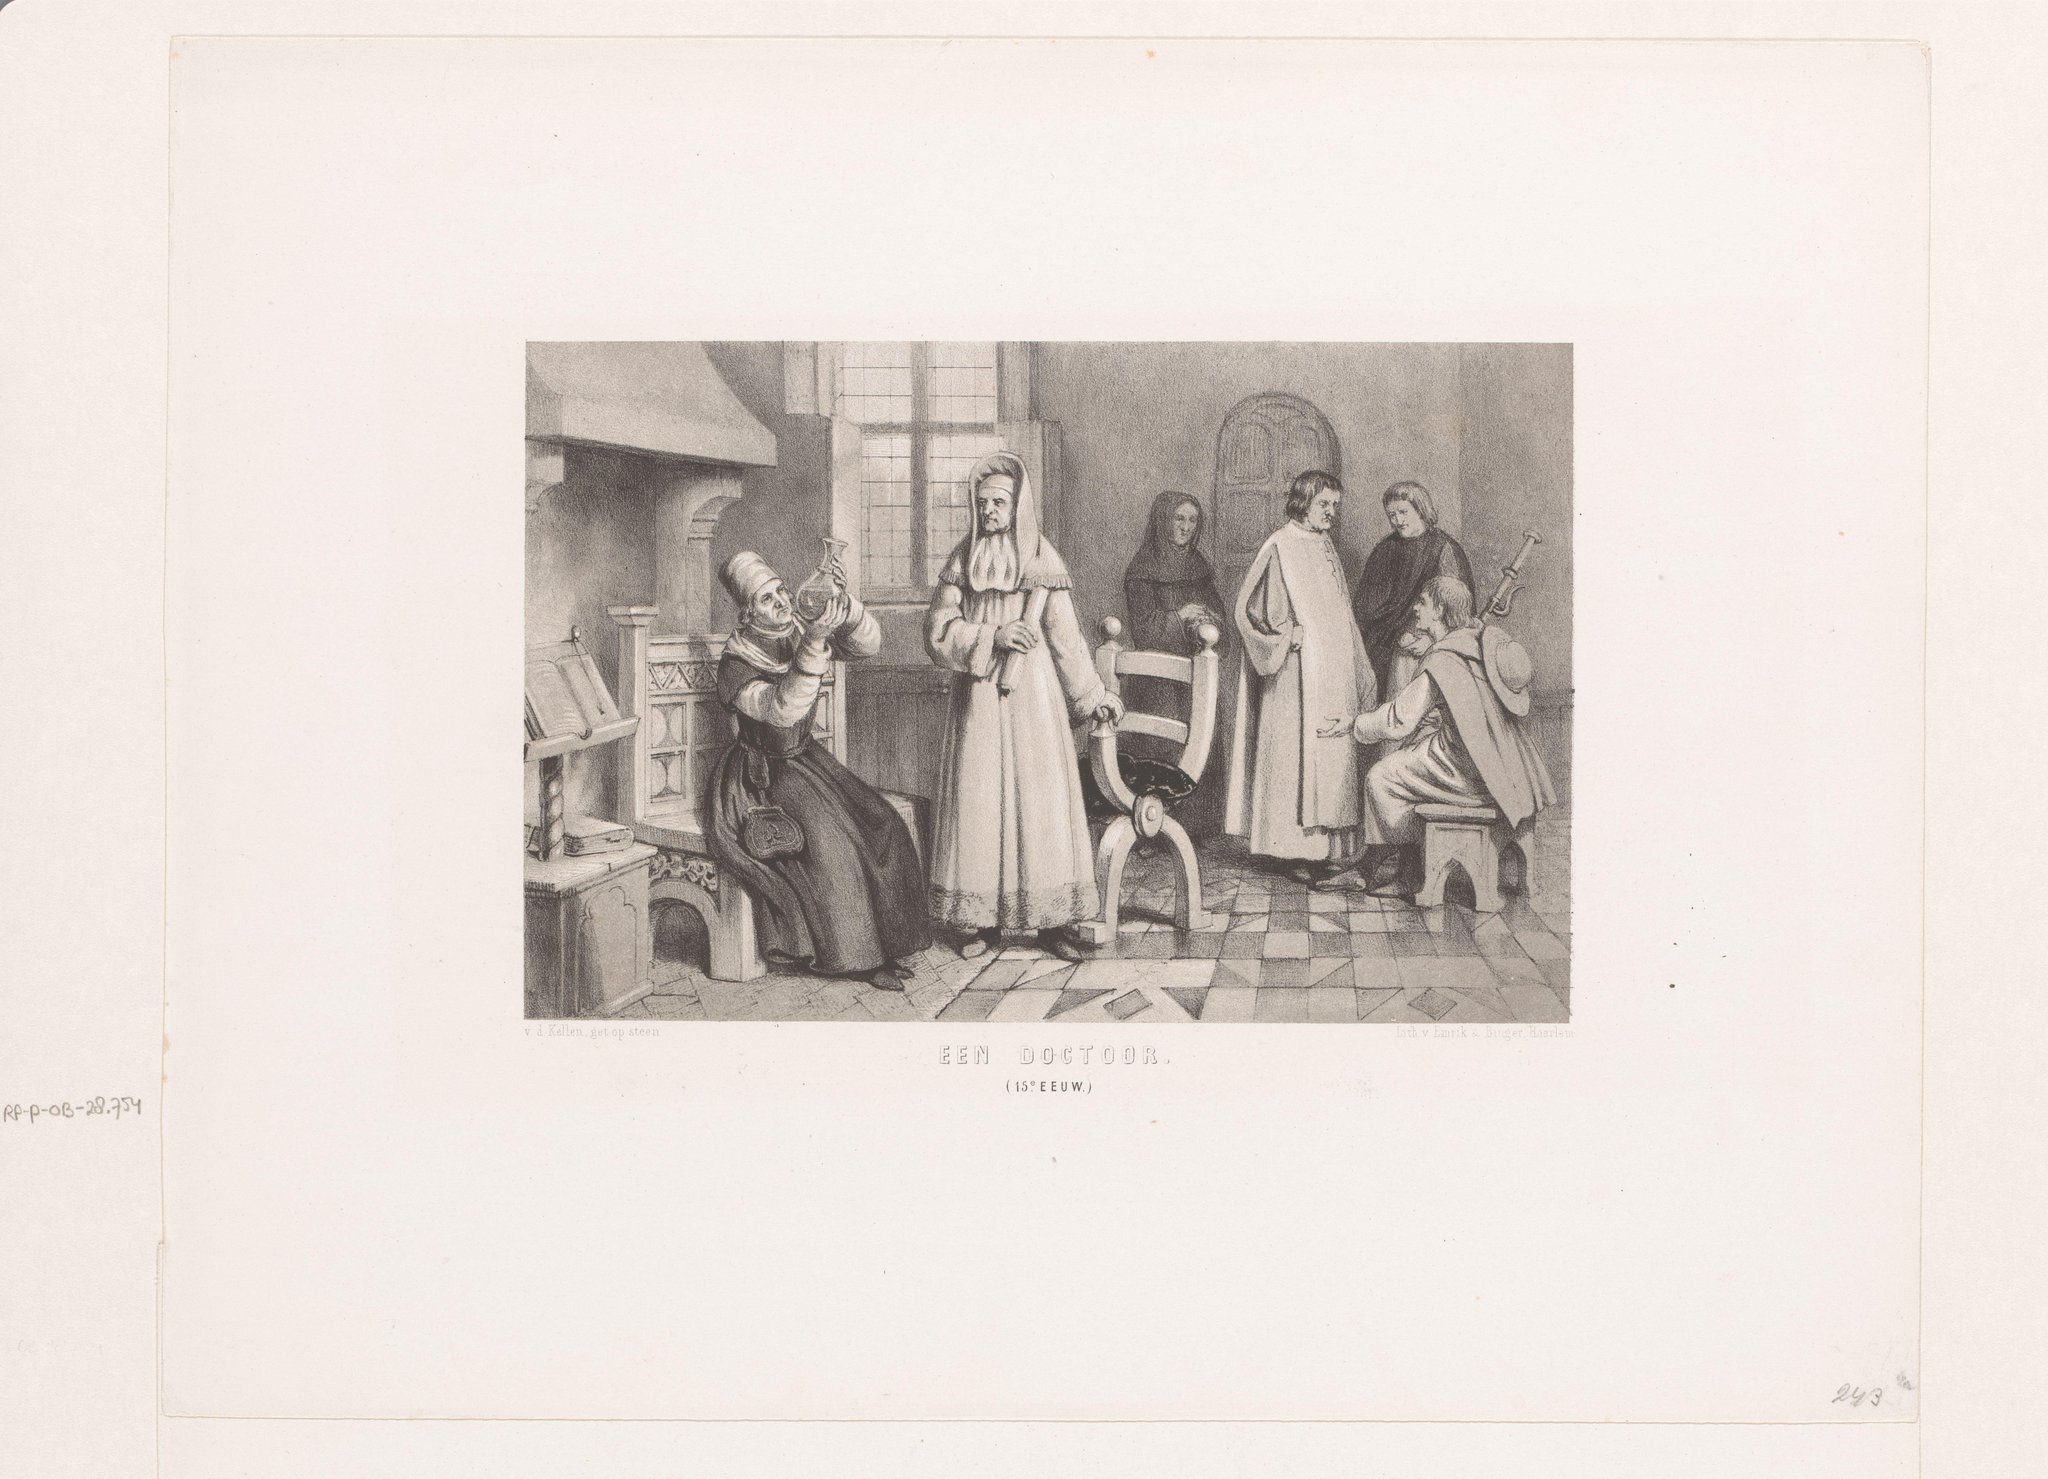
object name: print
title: Dokter in de vijftiende eeuw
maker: david van der kellen (1827-1895)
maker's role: draughtsman, print maker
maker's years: 1827-1895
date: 1837-1895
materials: paper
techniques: tone lithography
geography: haarlem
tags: physician, doctor, examination of urine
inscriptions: collector's mark: Lugt 2228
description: De dokter bekijkt de urine van de patiënt. In het interieur staan verschillende figuren. De patiënt zit op een kruk en praat met een geestelijke.